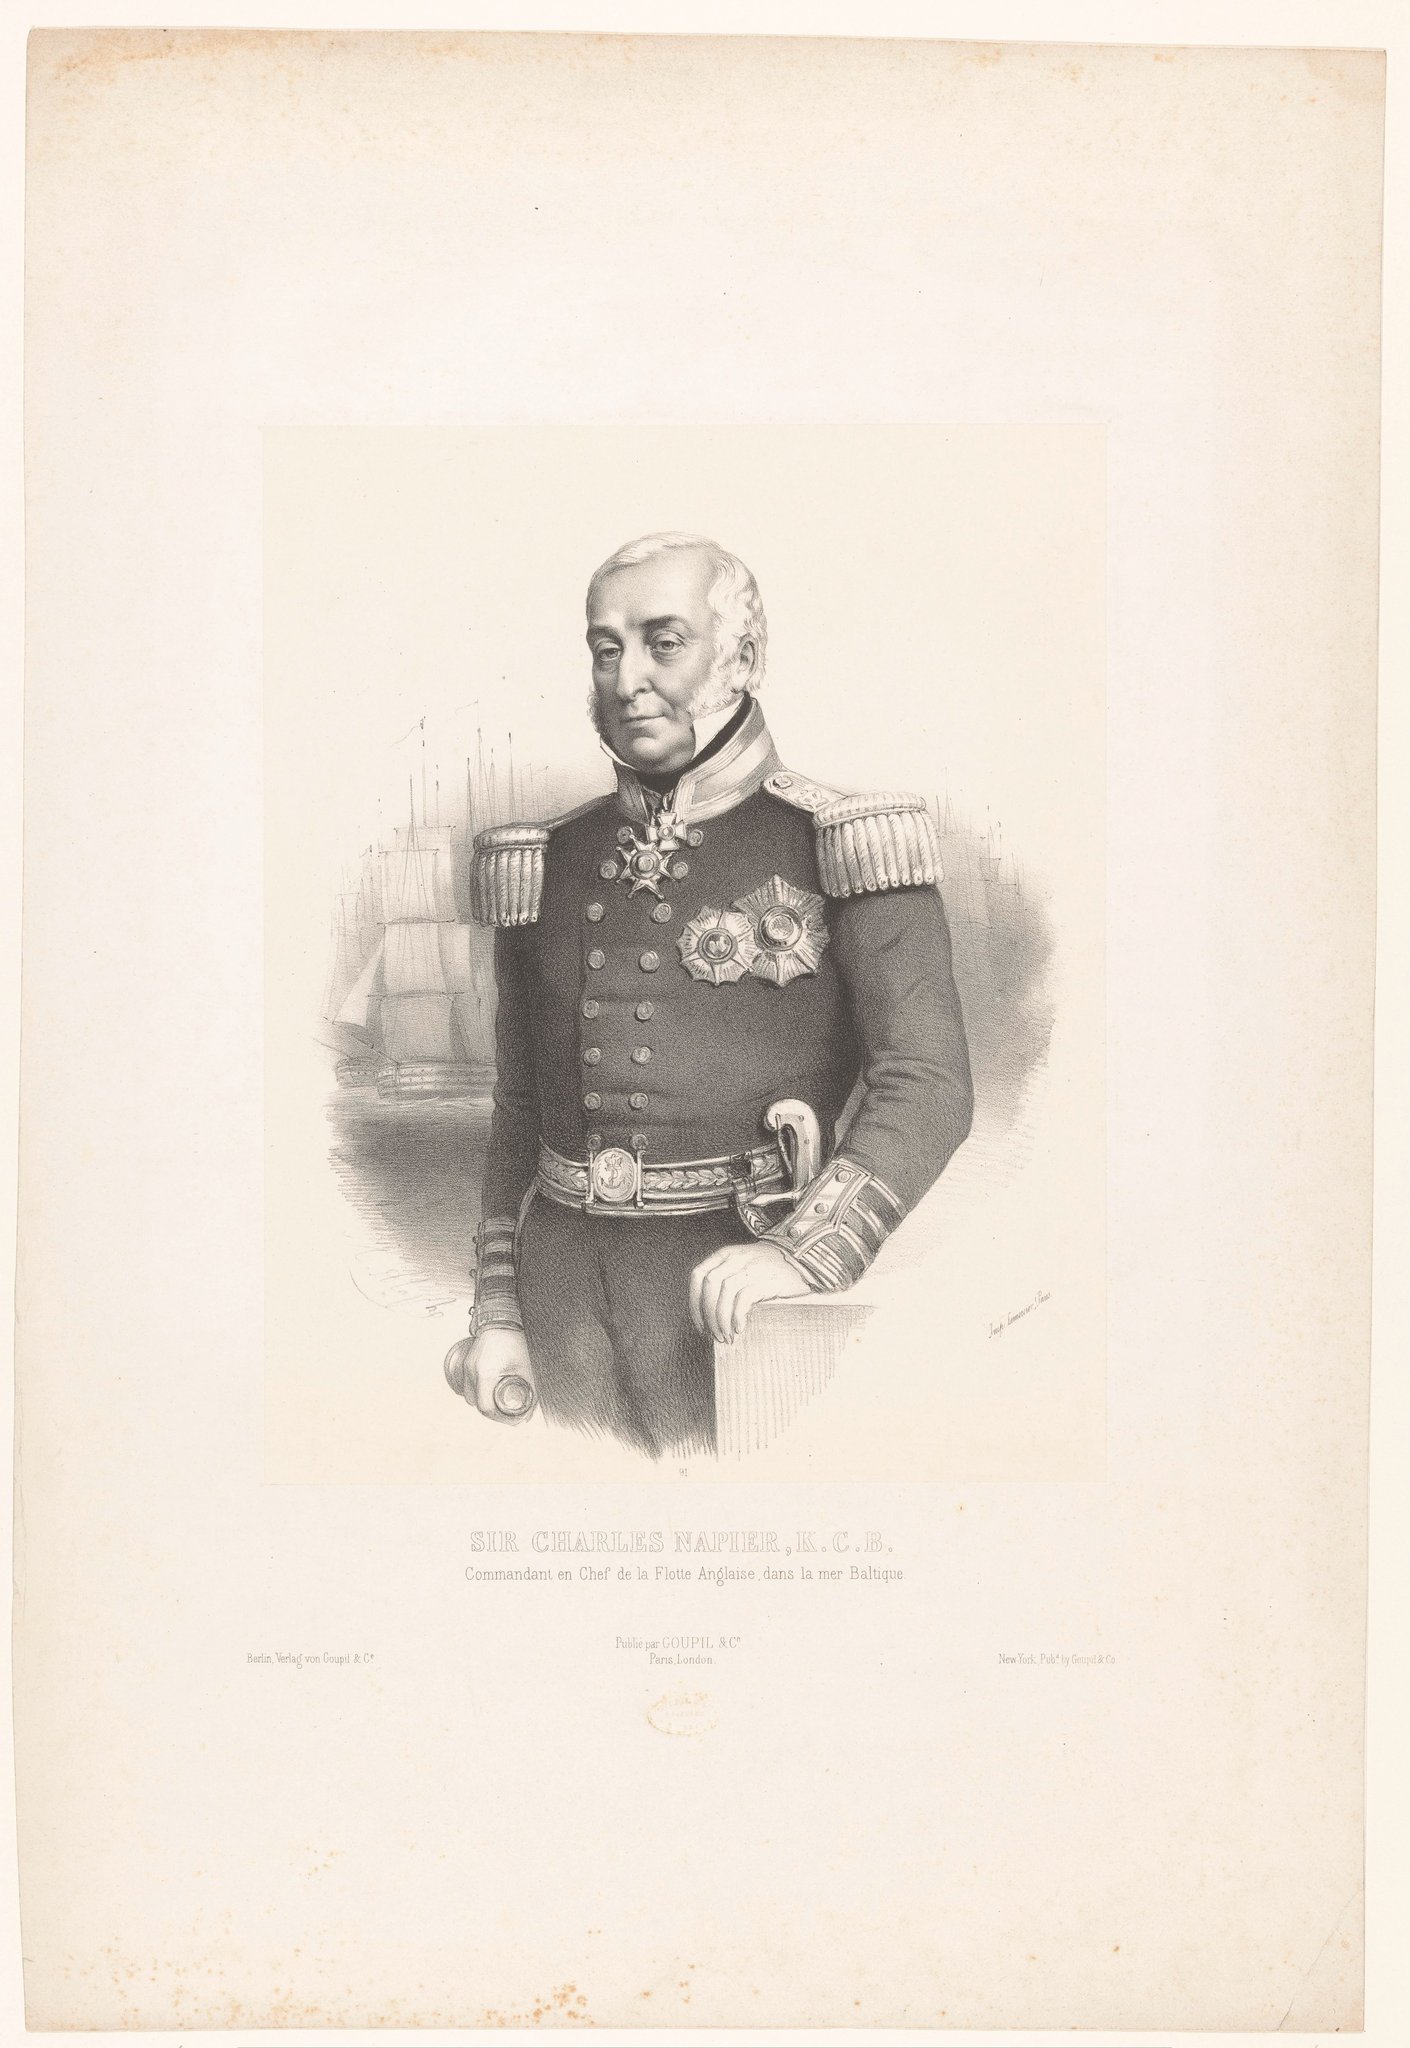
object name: print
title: Sir Charles Napier, K.C.B. Commandant en chef de la flotte anglaise, dans la mer Baltique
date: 1854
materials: paper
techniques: lithography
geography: paris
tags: naval officer, historical persons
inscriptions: check stamp: Lugt 1090, collector's mark: Lugt 2228